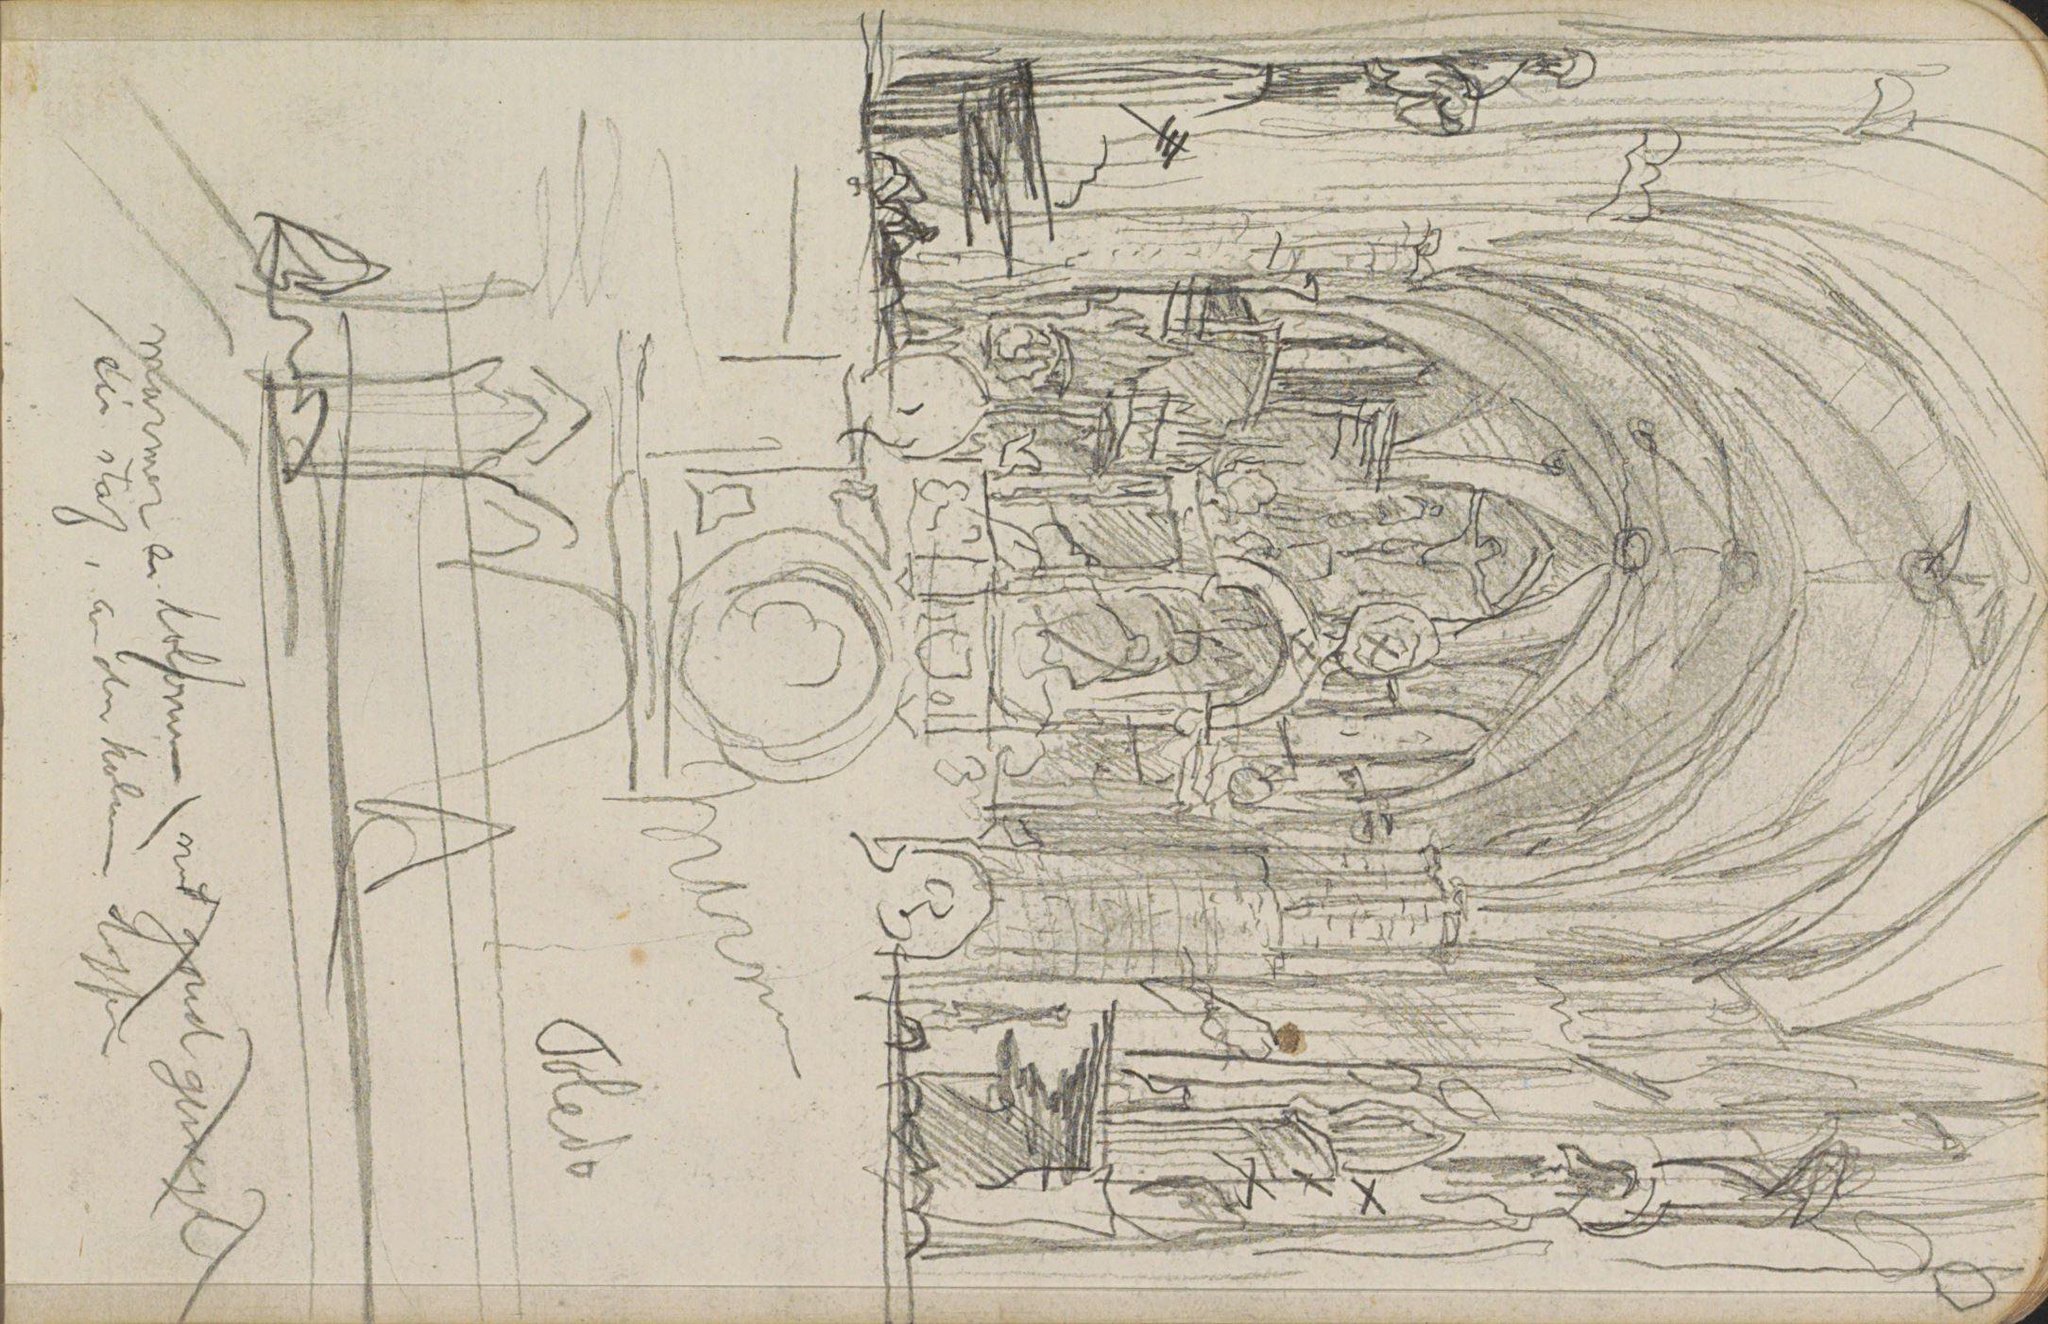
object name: sketchbook leaf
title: Interieur van de kathedraal van Toledo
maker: marius bauer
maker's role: draughtsman, print maker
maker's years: 1867-1932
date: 1902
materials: paper, pencil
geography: toledo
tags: the cross ~ symbols of christ, interior of church, toledo cathedral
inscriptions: annotation: ‘Toledo’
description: Aan de wand een beeld van Christus aan het kruis. Pagina 27 uit een schetsboek met 30 bladen.